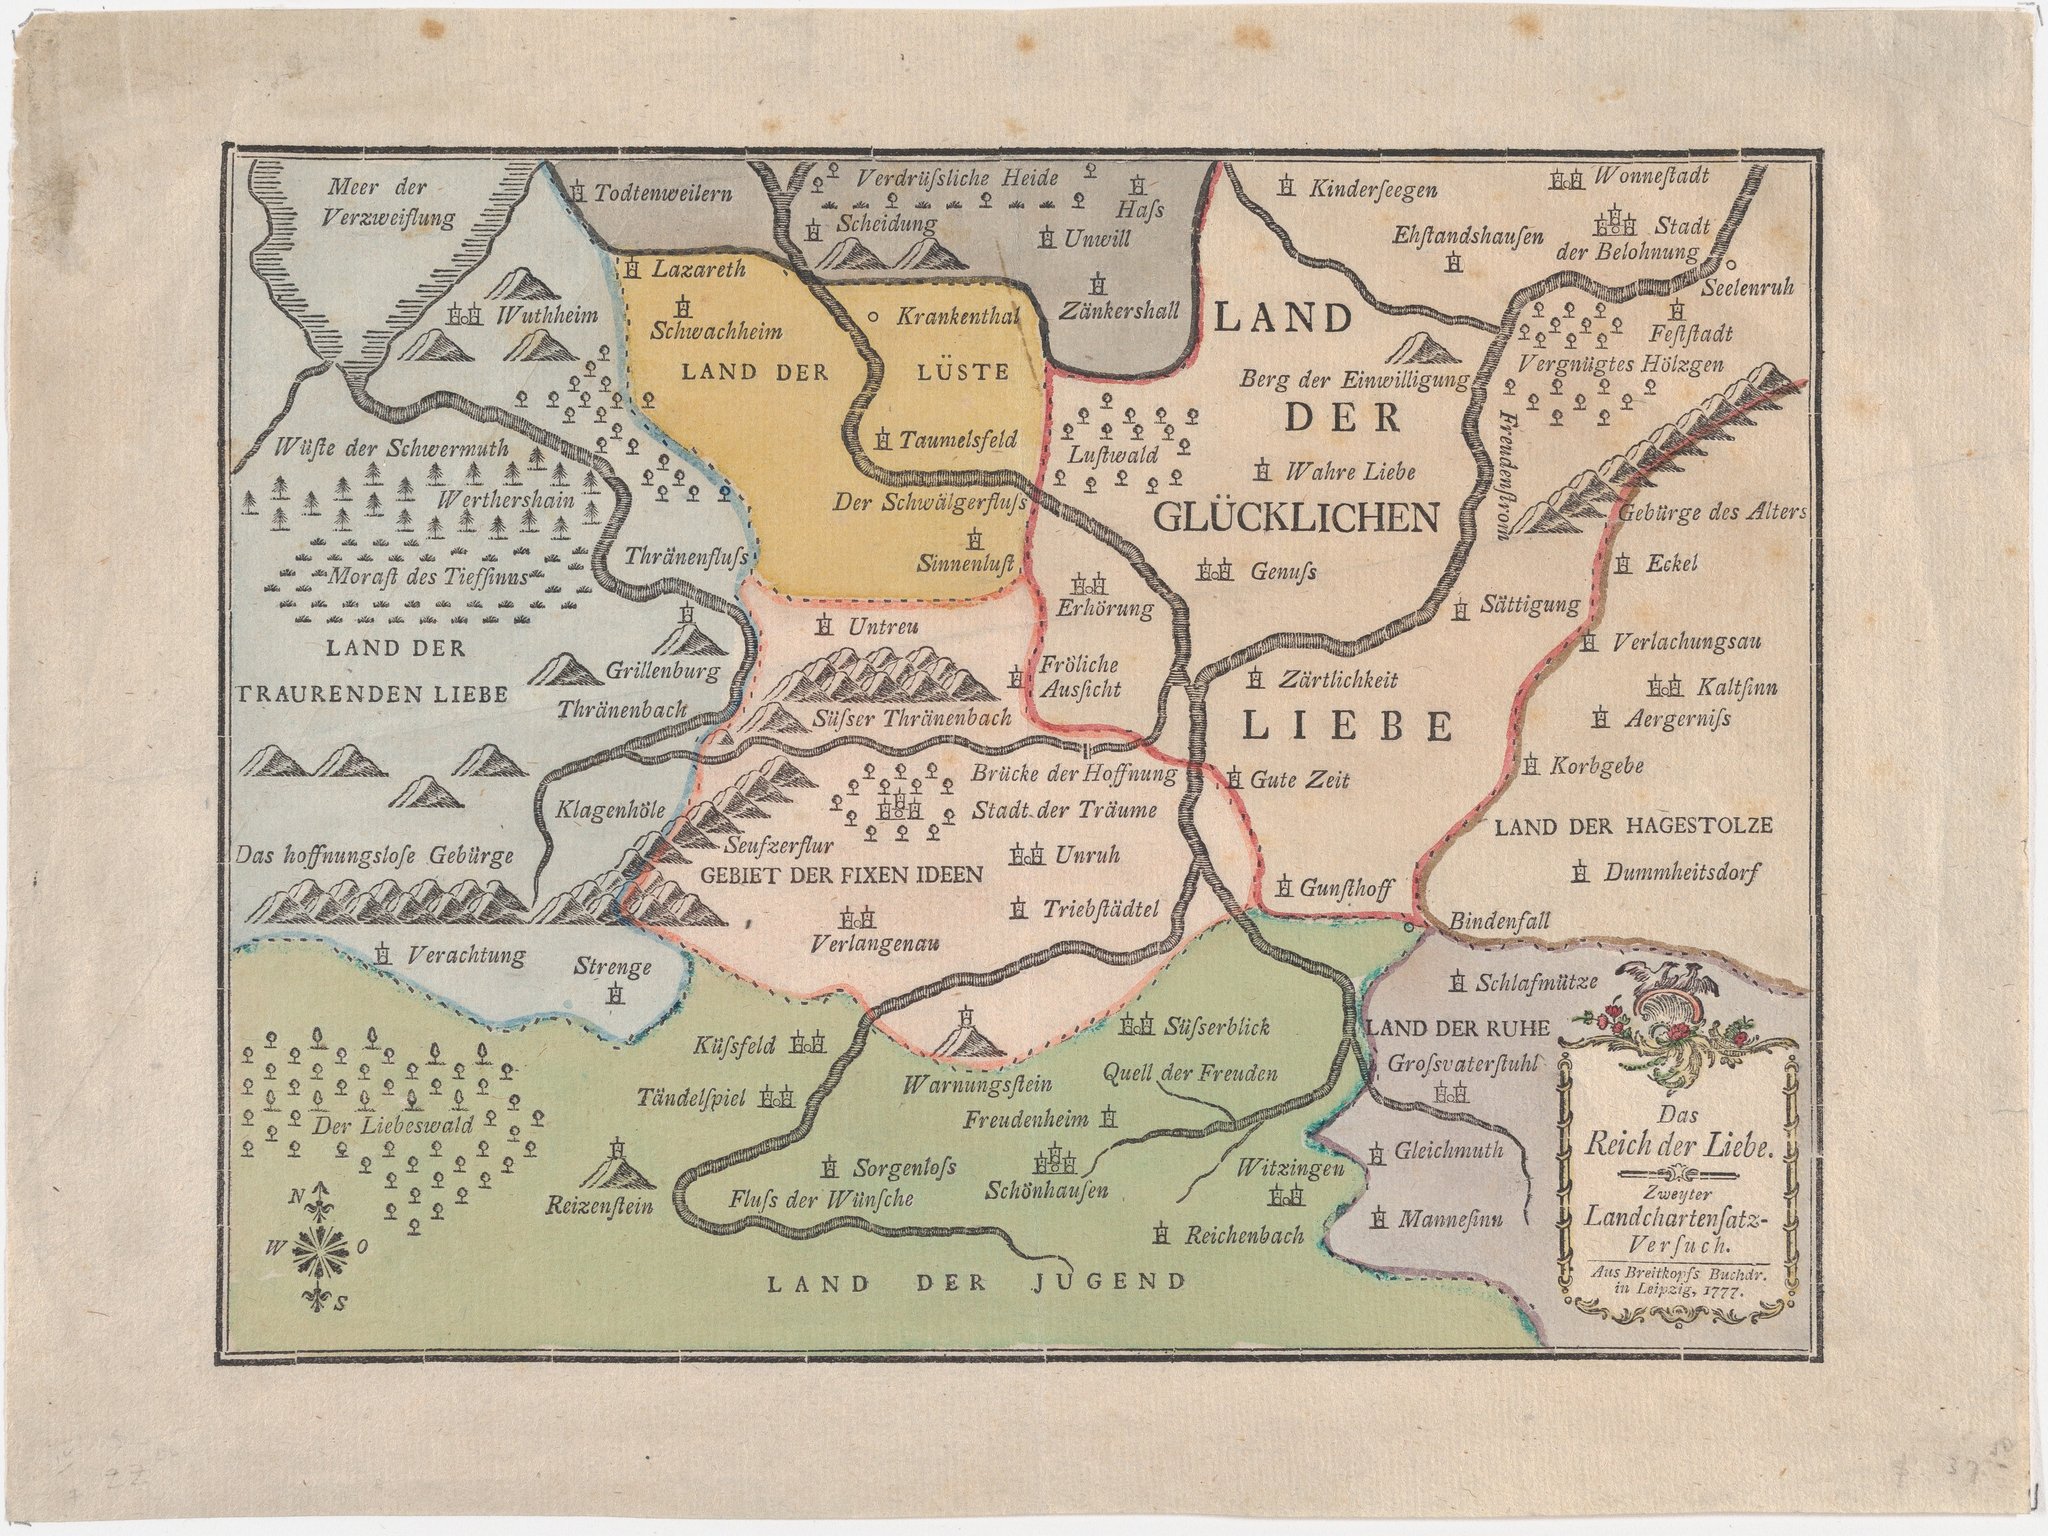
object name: valentine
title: Valentine: Map of the Kingdom of Love (Das Reich der Liebe)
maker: breitkopf & härtel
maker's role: artist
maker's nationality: german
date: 1777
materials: paper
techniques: hand coloring, printing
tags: maps